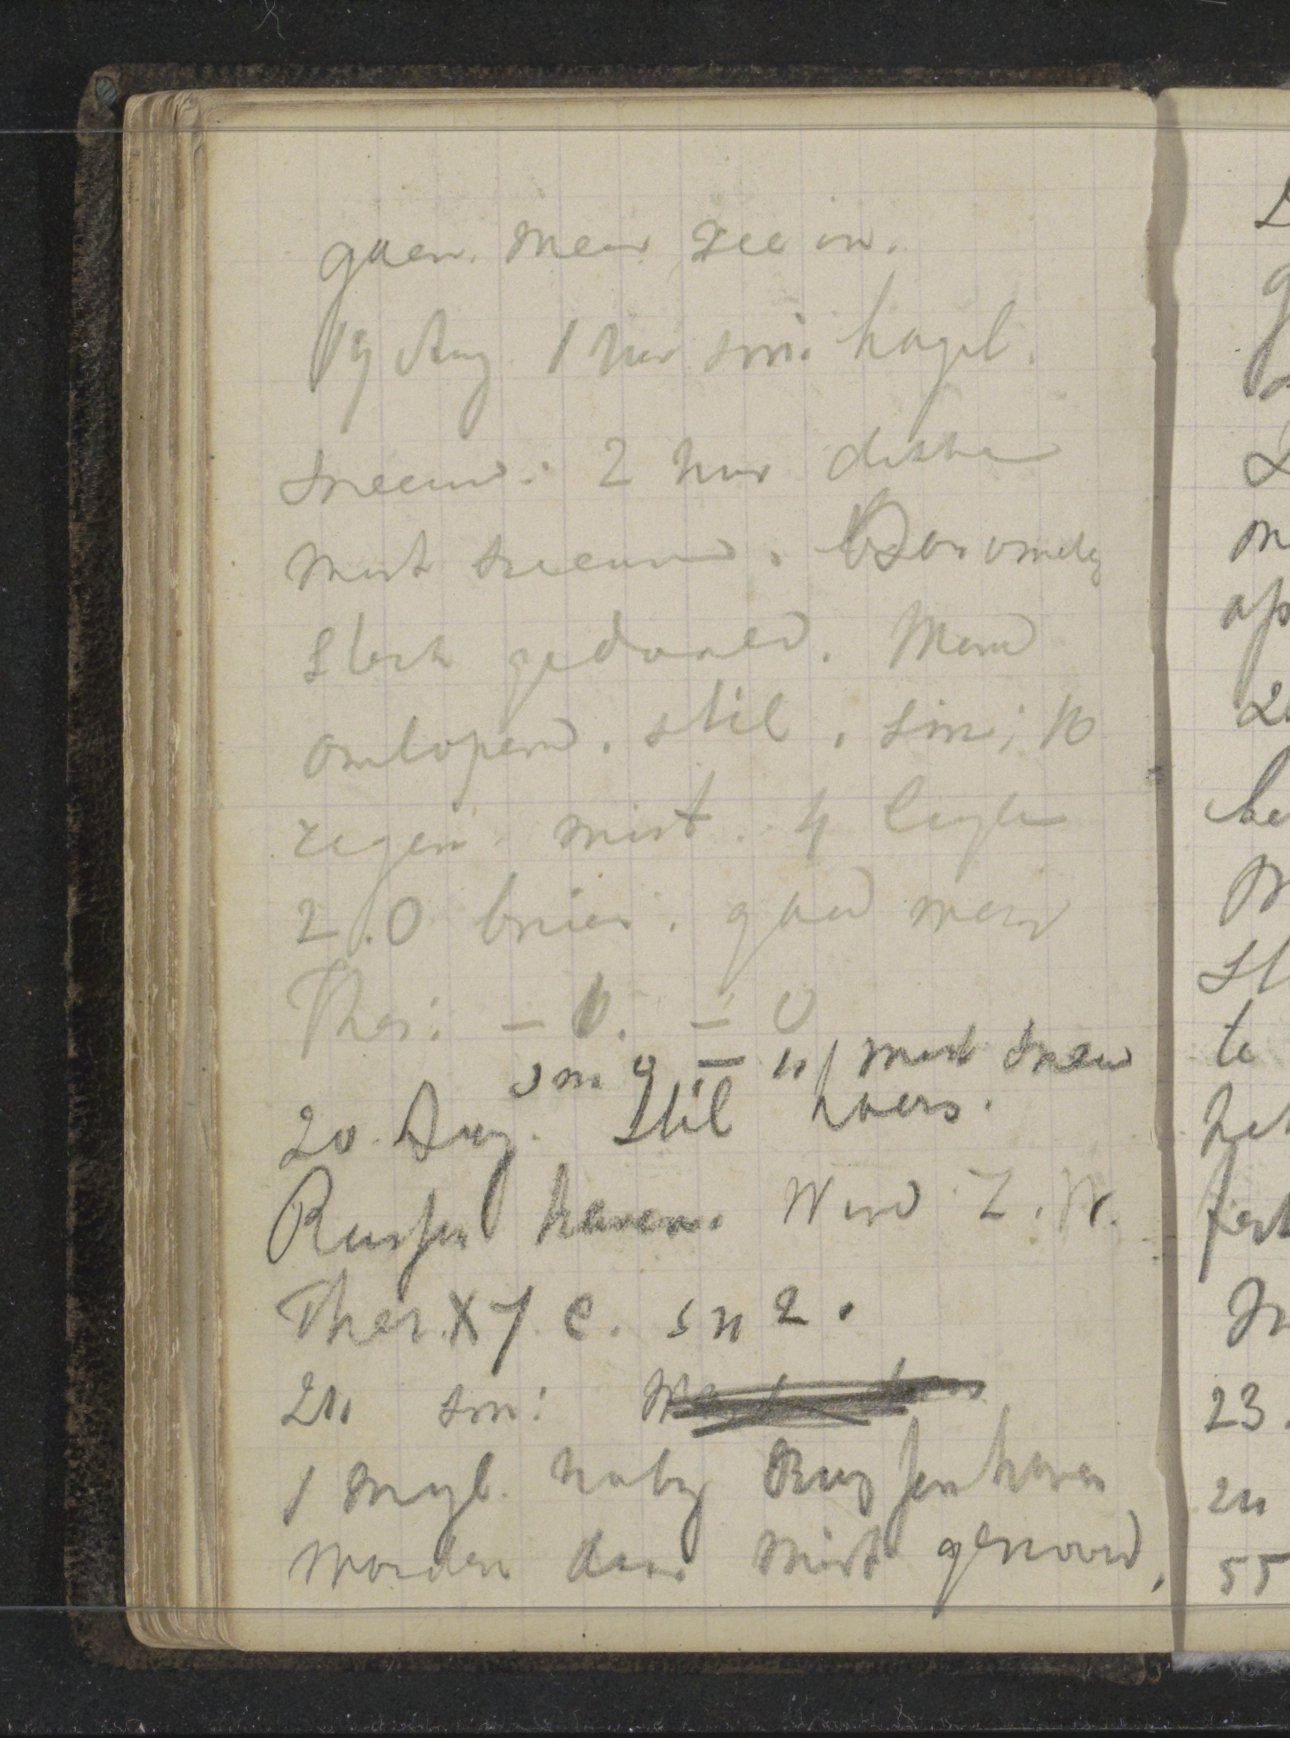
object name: sketchbook leaf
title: Reisverslag van medio augustus 1880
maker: louis apol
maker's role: draughtsman, painter, print maker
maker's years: 1850-1936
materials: chalk, pencil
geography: novaya zemlya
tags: nova zembla expedities 1880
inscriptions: annotation: ‘[...]’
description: Blad 33 verso uit een schetsboek met 110 bladen betekend tijdens de expeditie naar Nova Zembla in 1880.